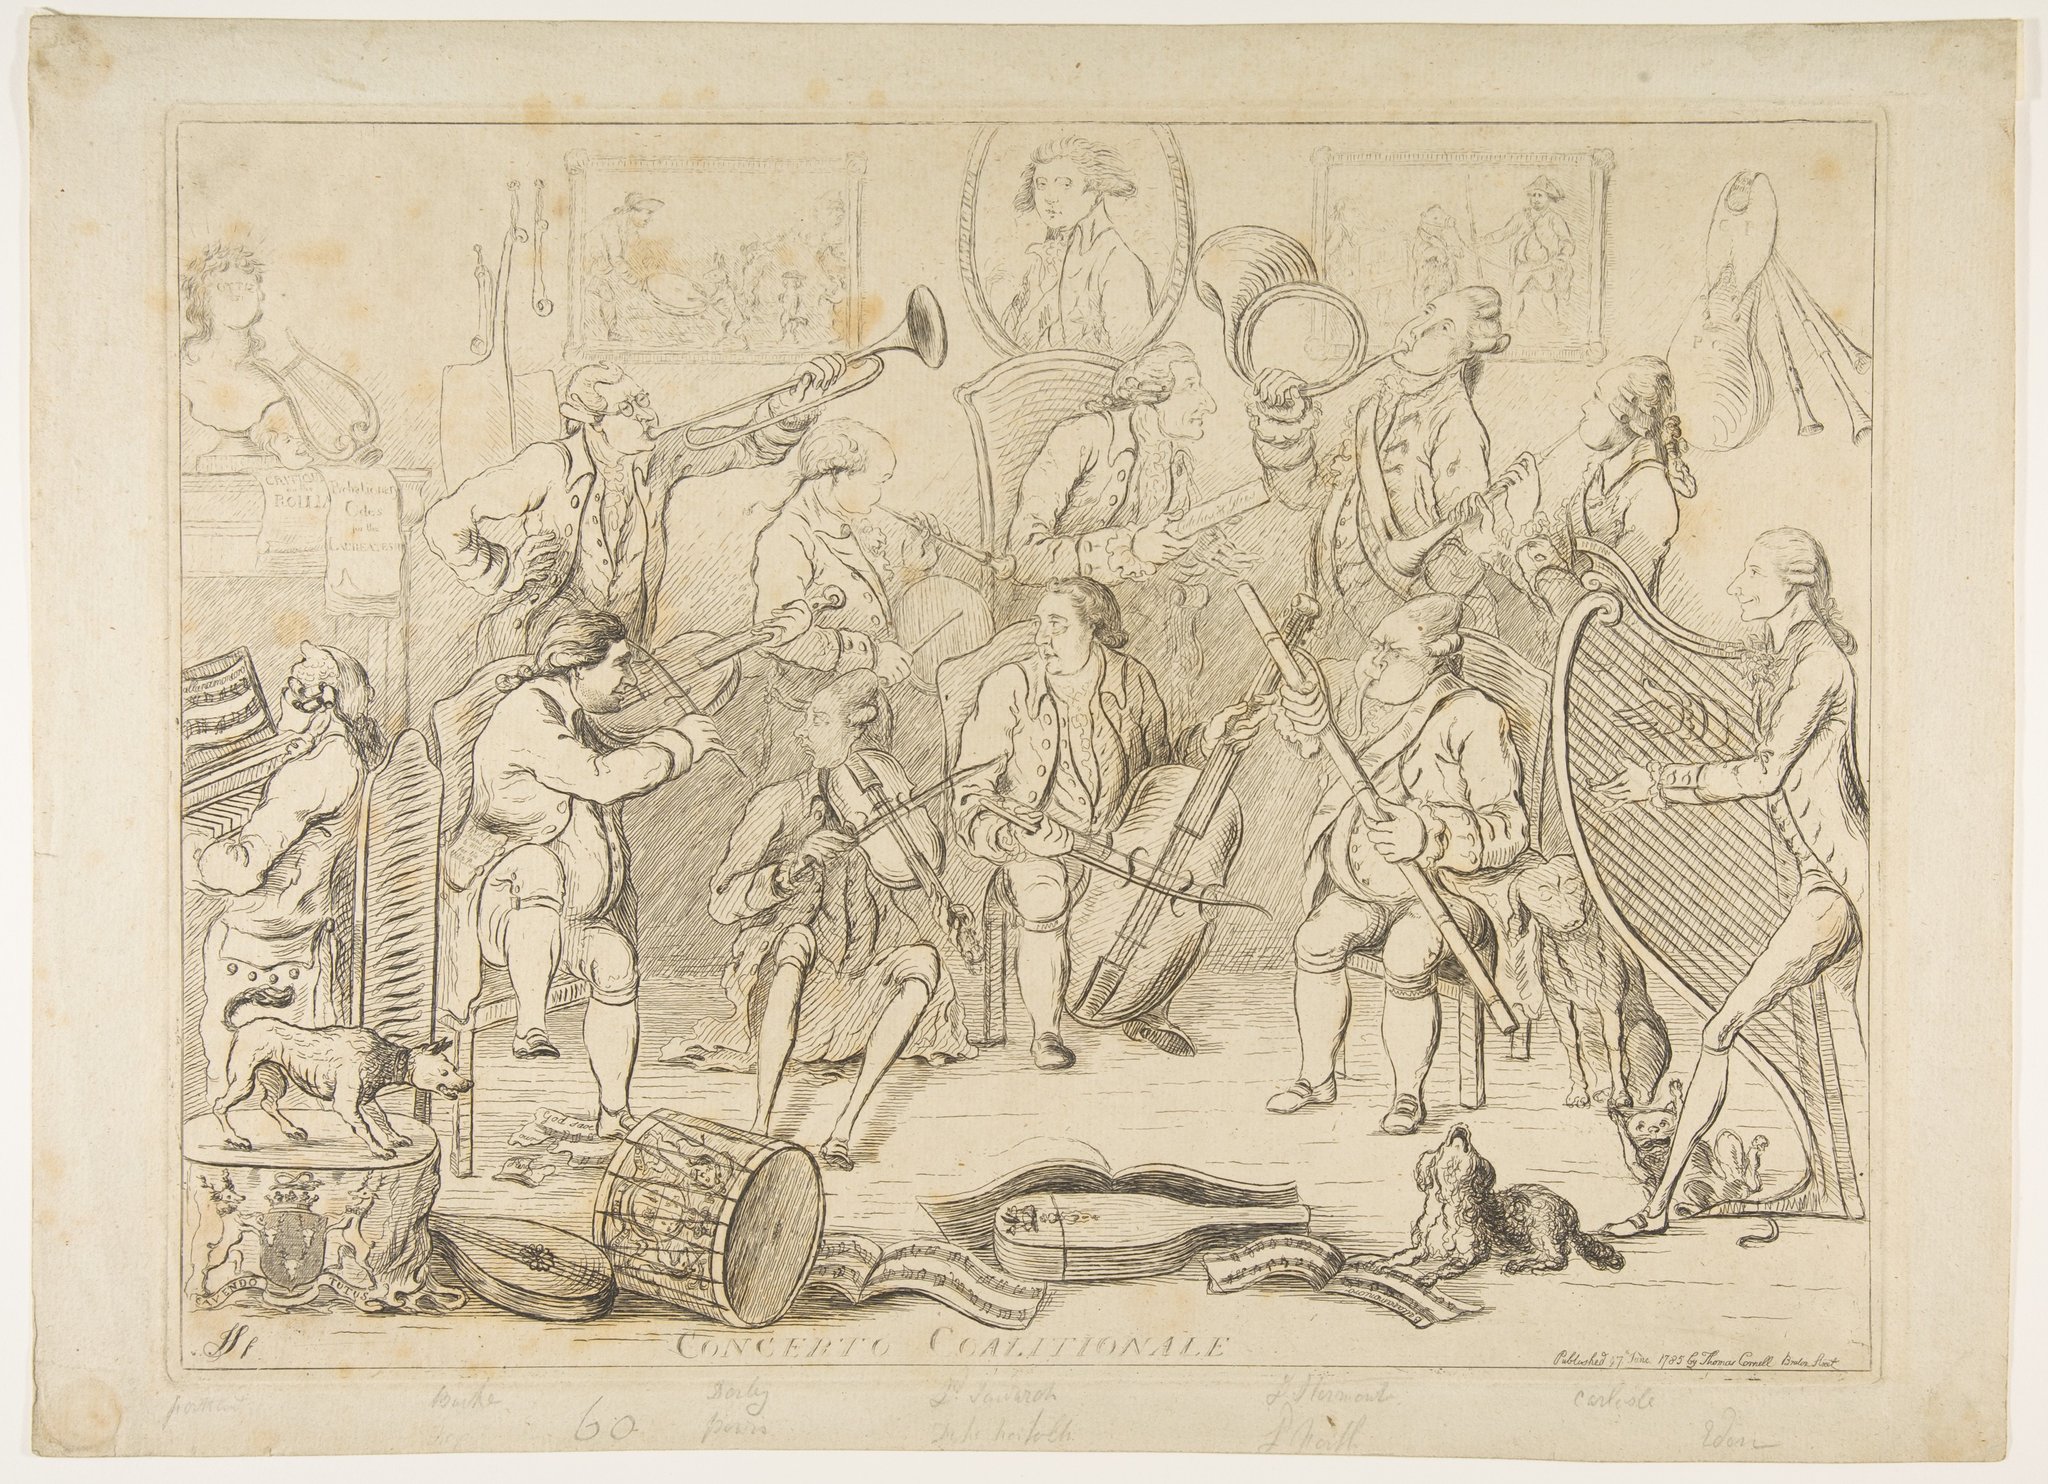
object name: print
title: Concerto Coalitionale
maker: james sayers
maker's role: artist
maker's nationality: british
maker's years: 1748-1823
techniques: etching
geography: england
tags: musical instruments,satire,men,musicians,politics